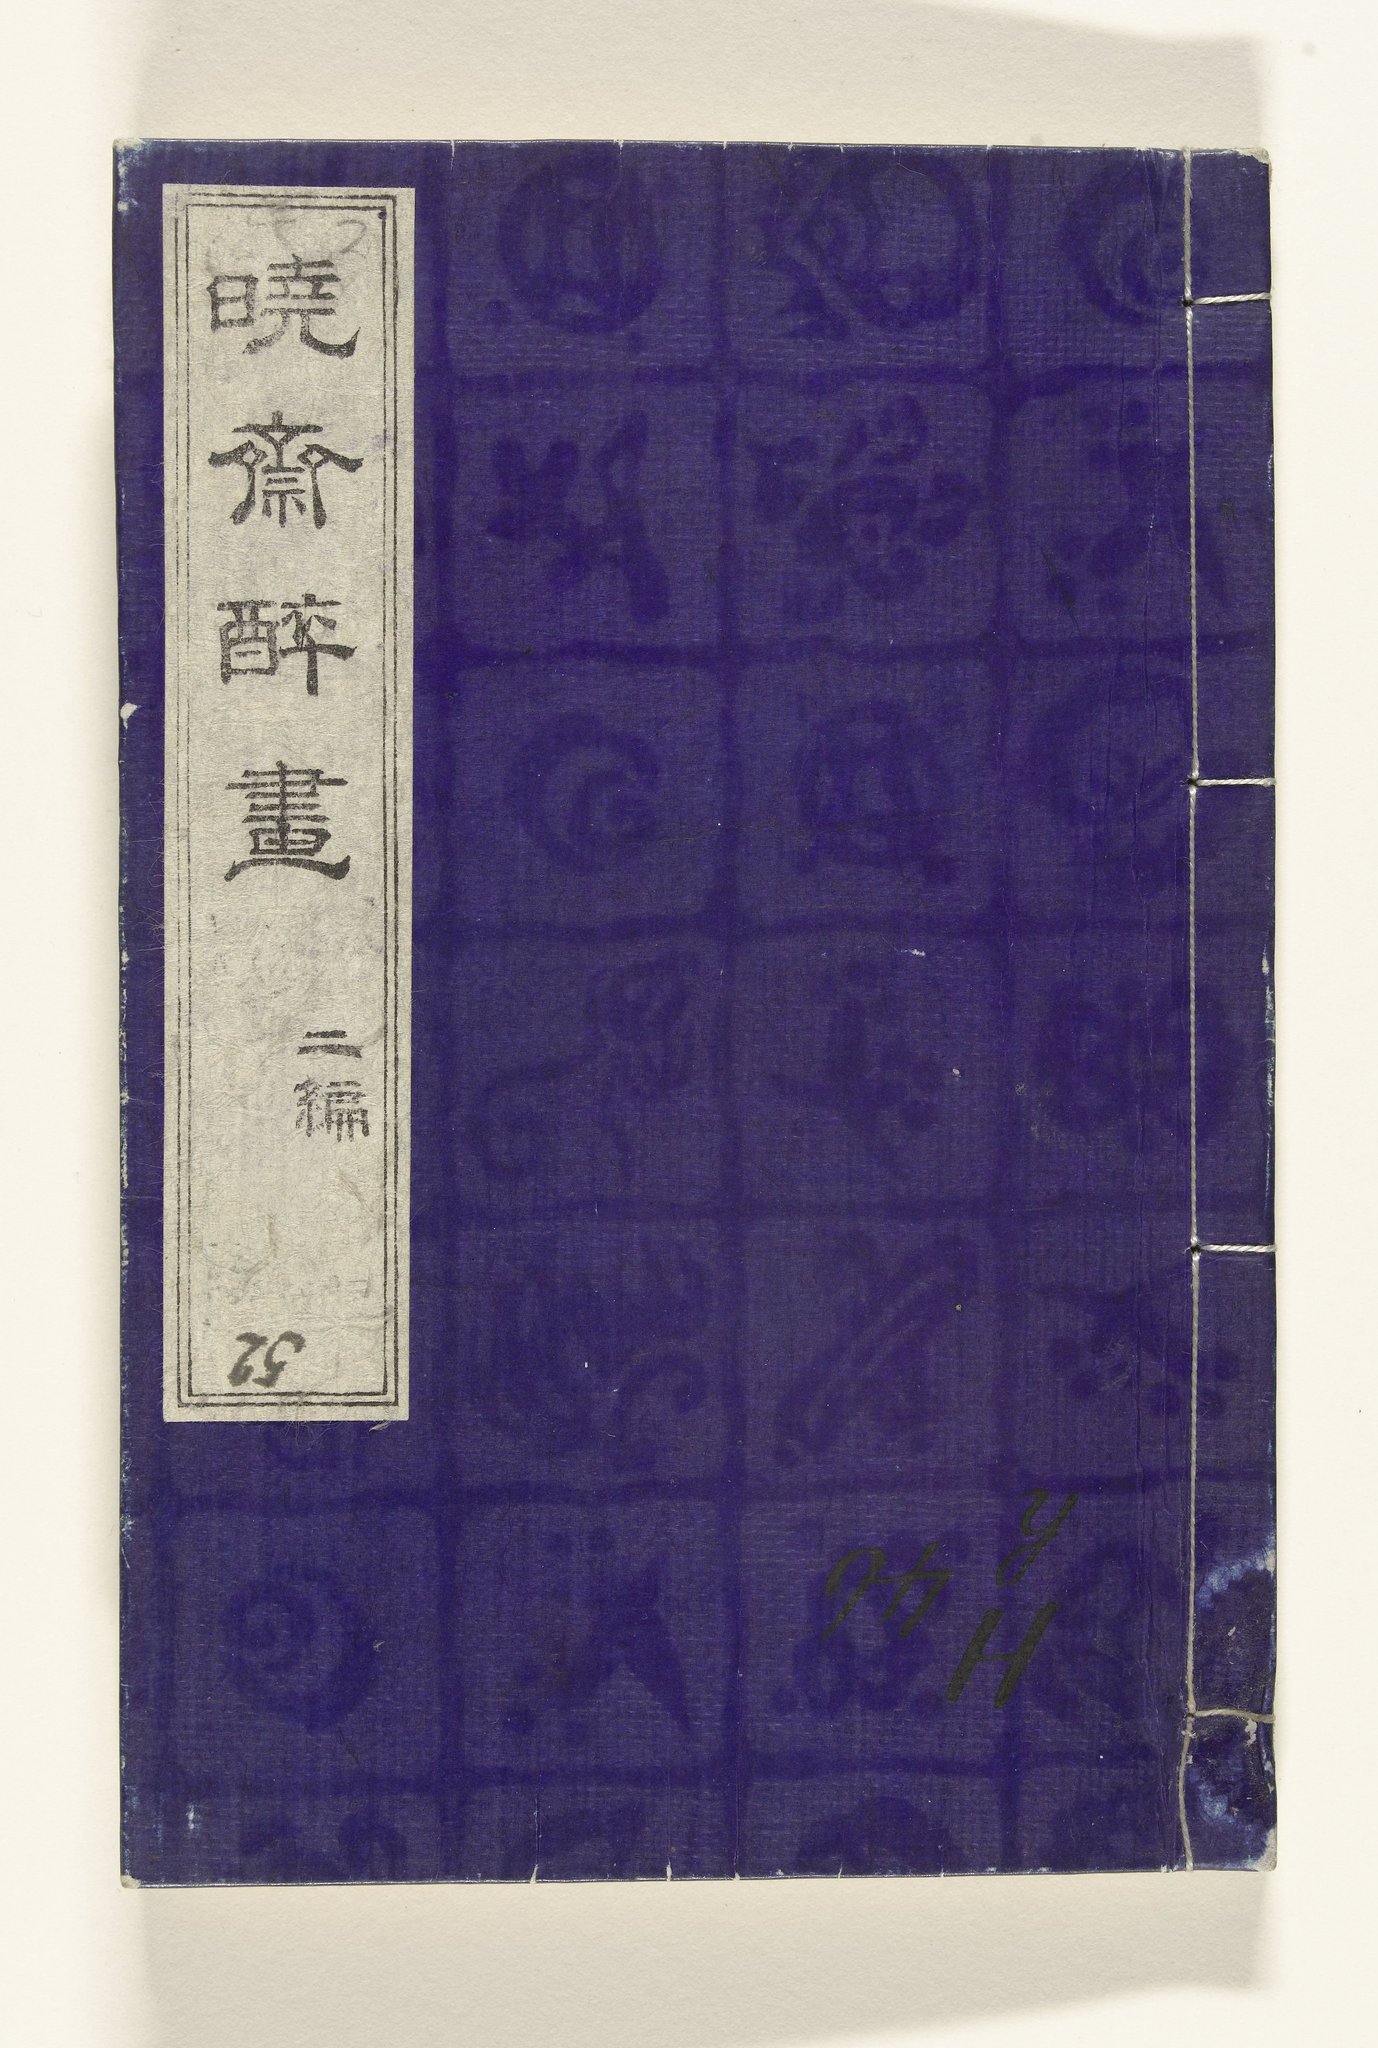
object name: book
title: Dronken tekeningen van Kyosai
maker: kawanabe kyôsai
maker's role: draughtsman, print maker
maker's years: 1831-1889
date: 1883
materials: paper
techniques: woodcut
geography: tokyo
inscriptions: collector's mark: ‘Rijksschool voor kunstnijverheid’ Lugt 3937